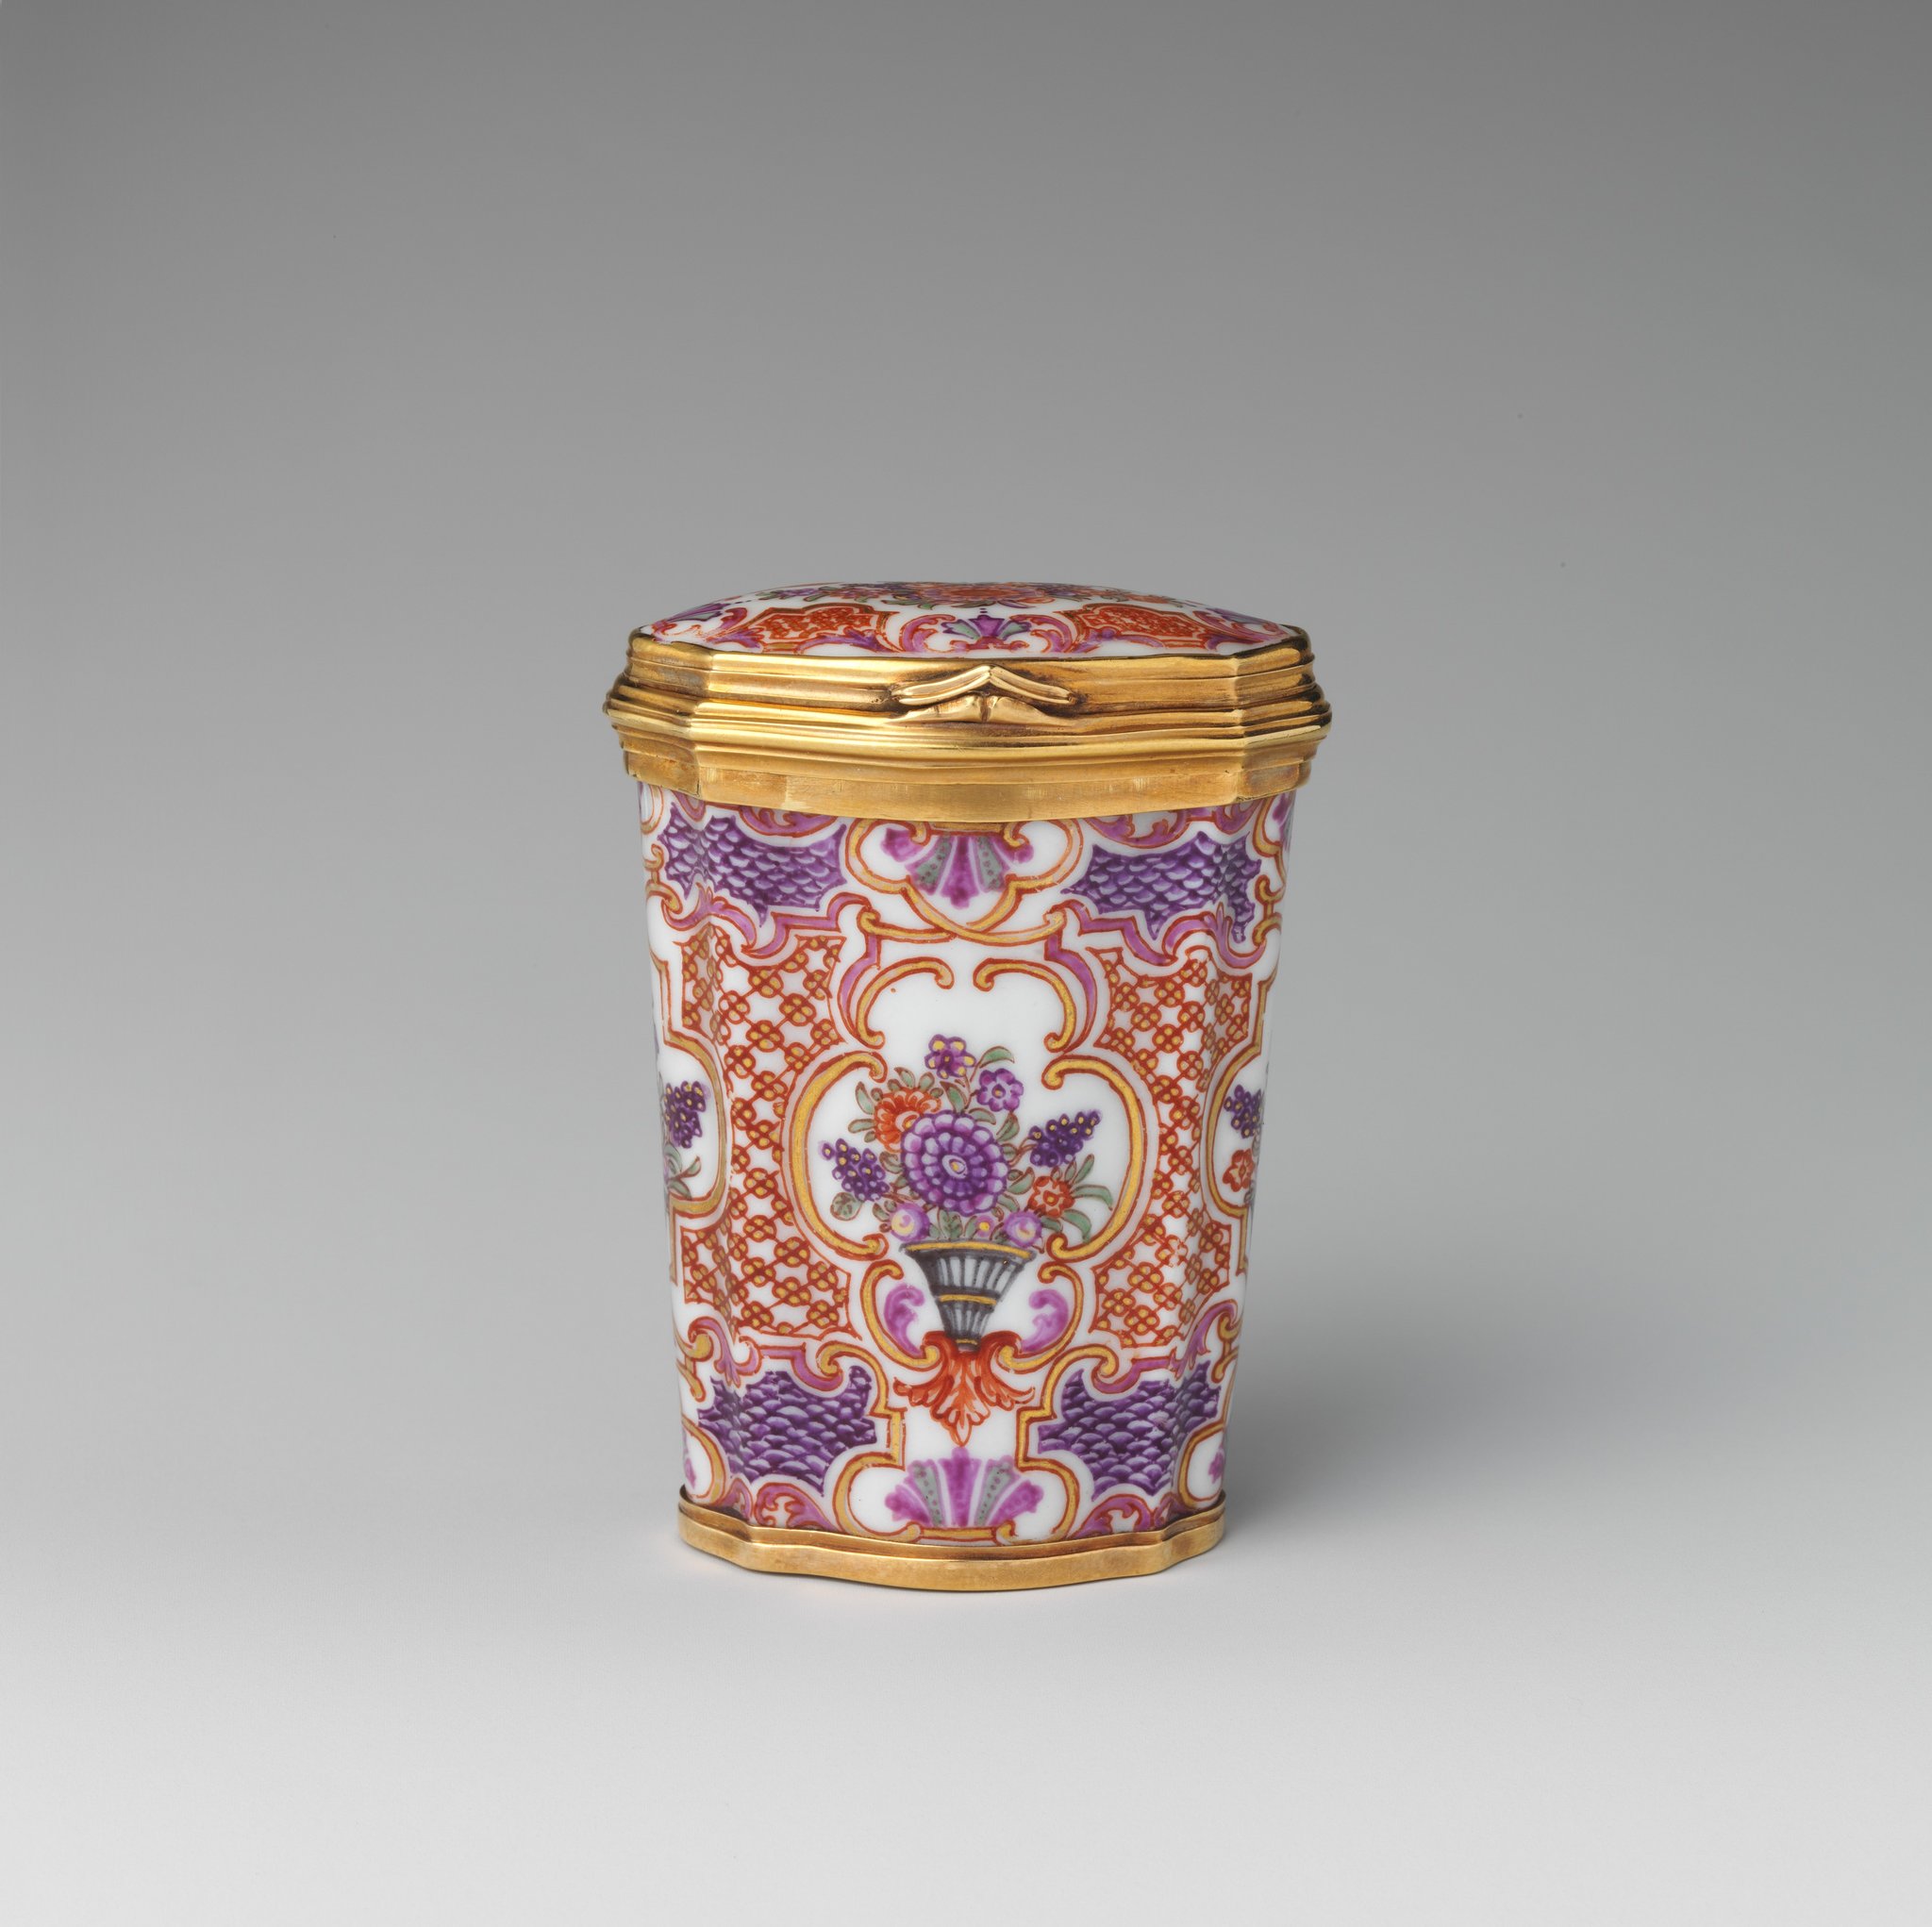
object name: étui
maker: vienna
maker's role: manufactory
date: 1735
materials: gold, hard paste porcelain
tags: flowers